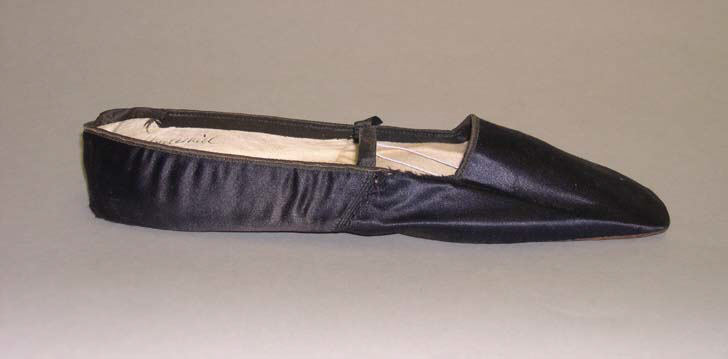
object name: slipper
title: Slippers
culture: american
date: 1840-1849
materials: silk